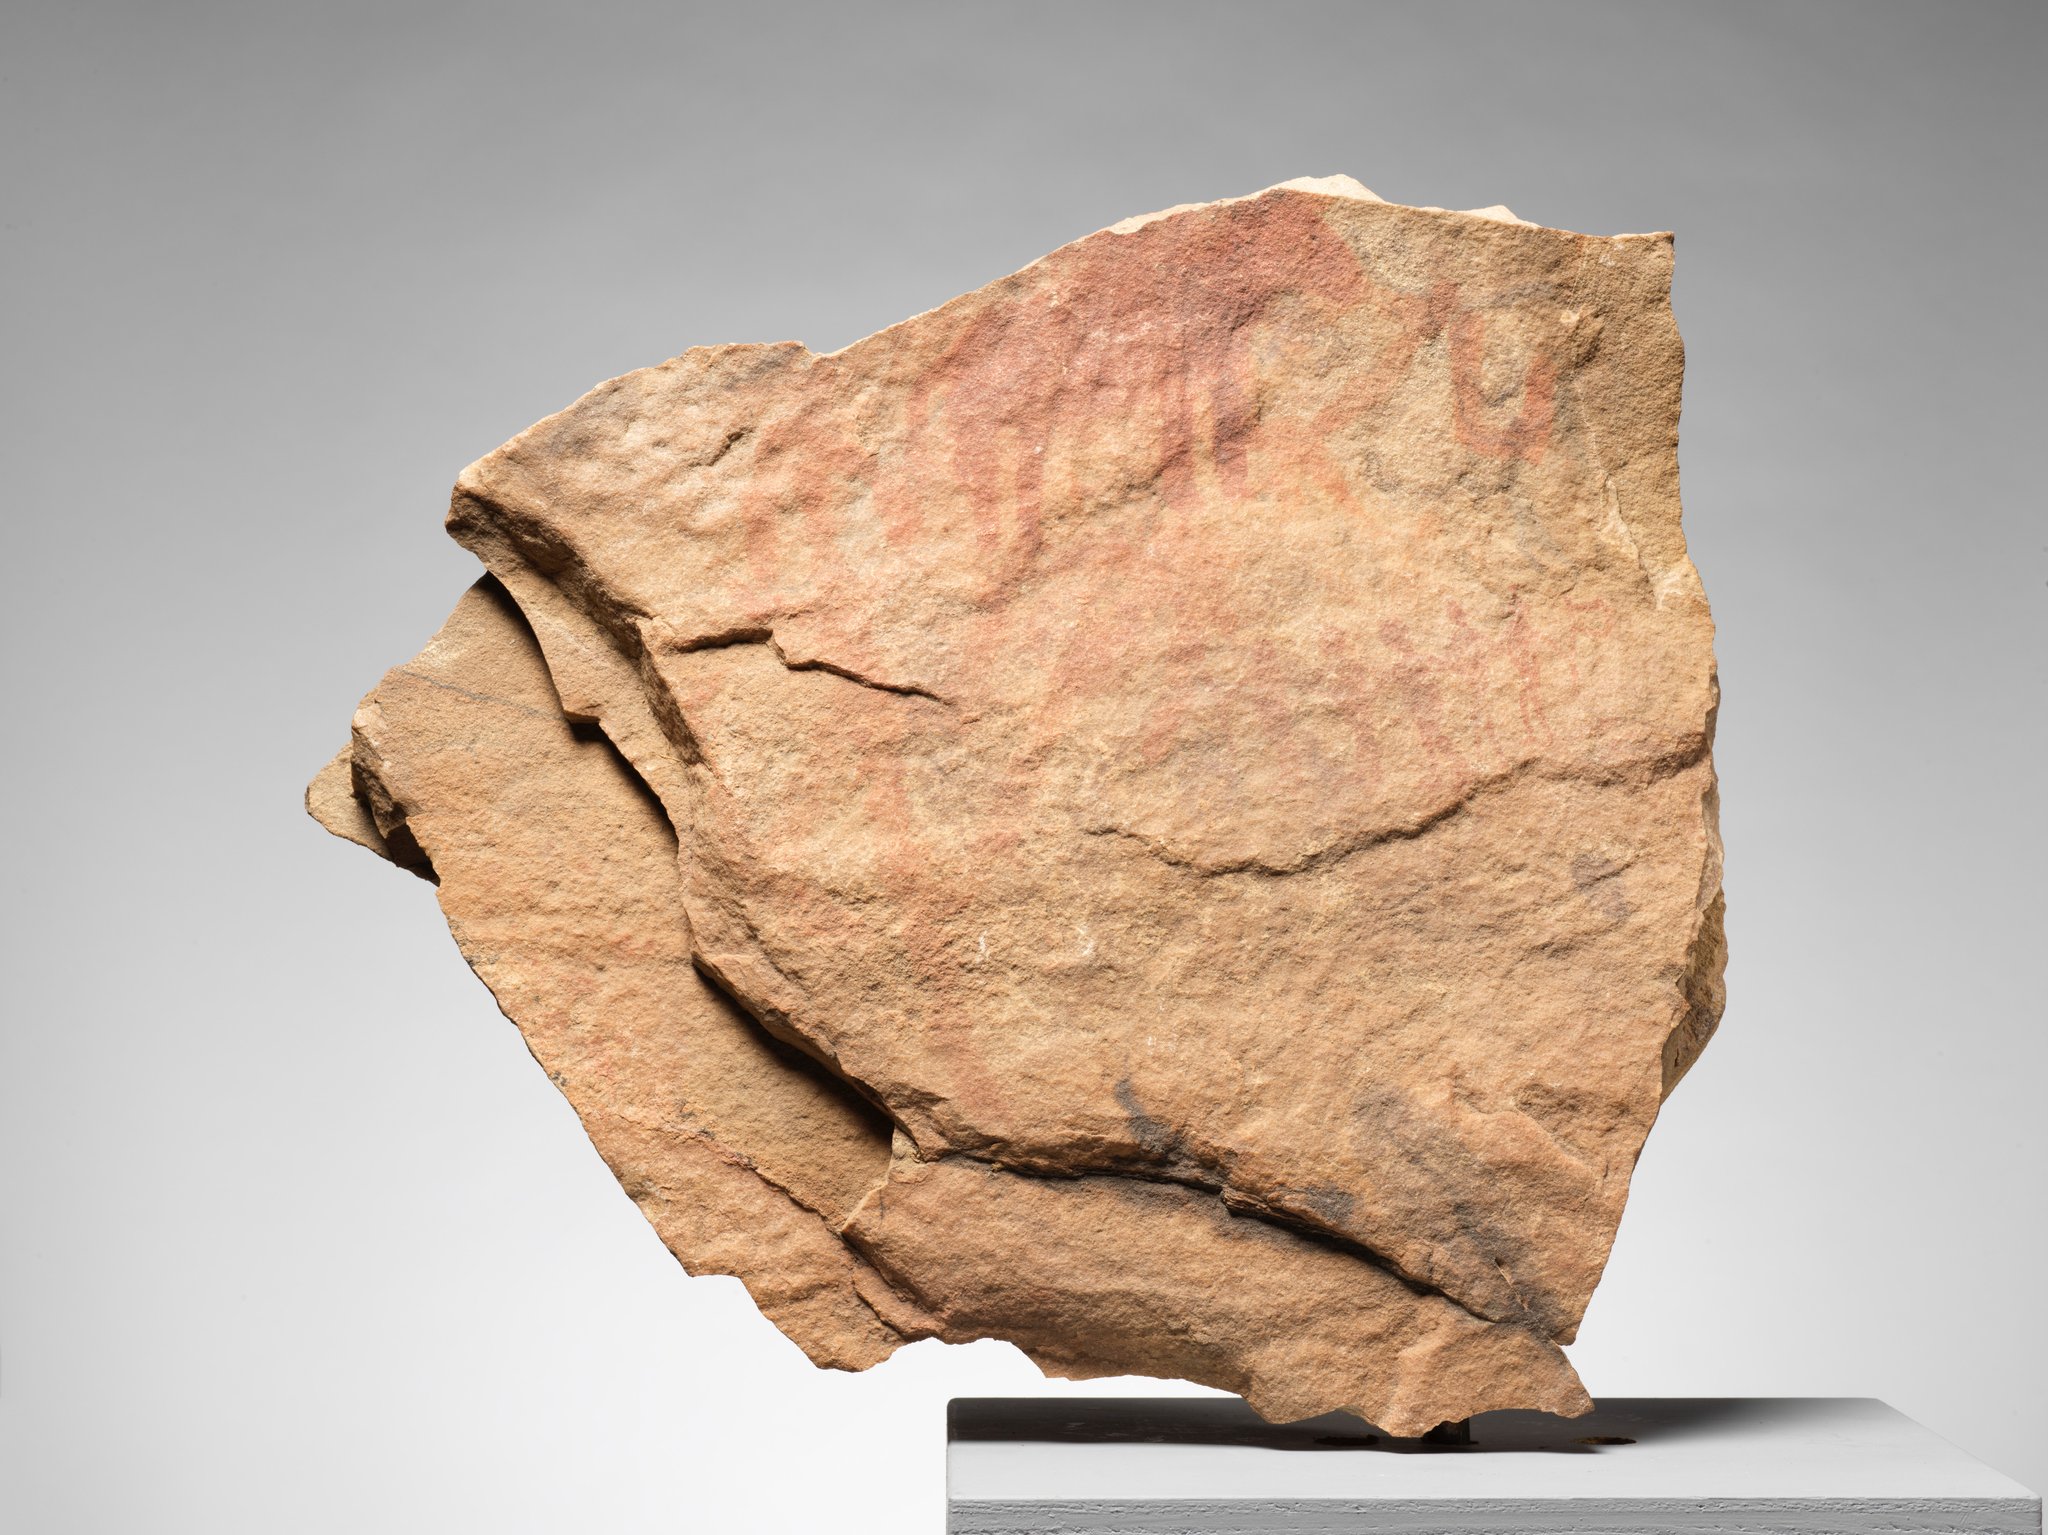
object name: painting fragment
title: Section of a Rock Painting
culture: indian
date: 1000 BCE-300 CE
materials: pigment, stone